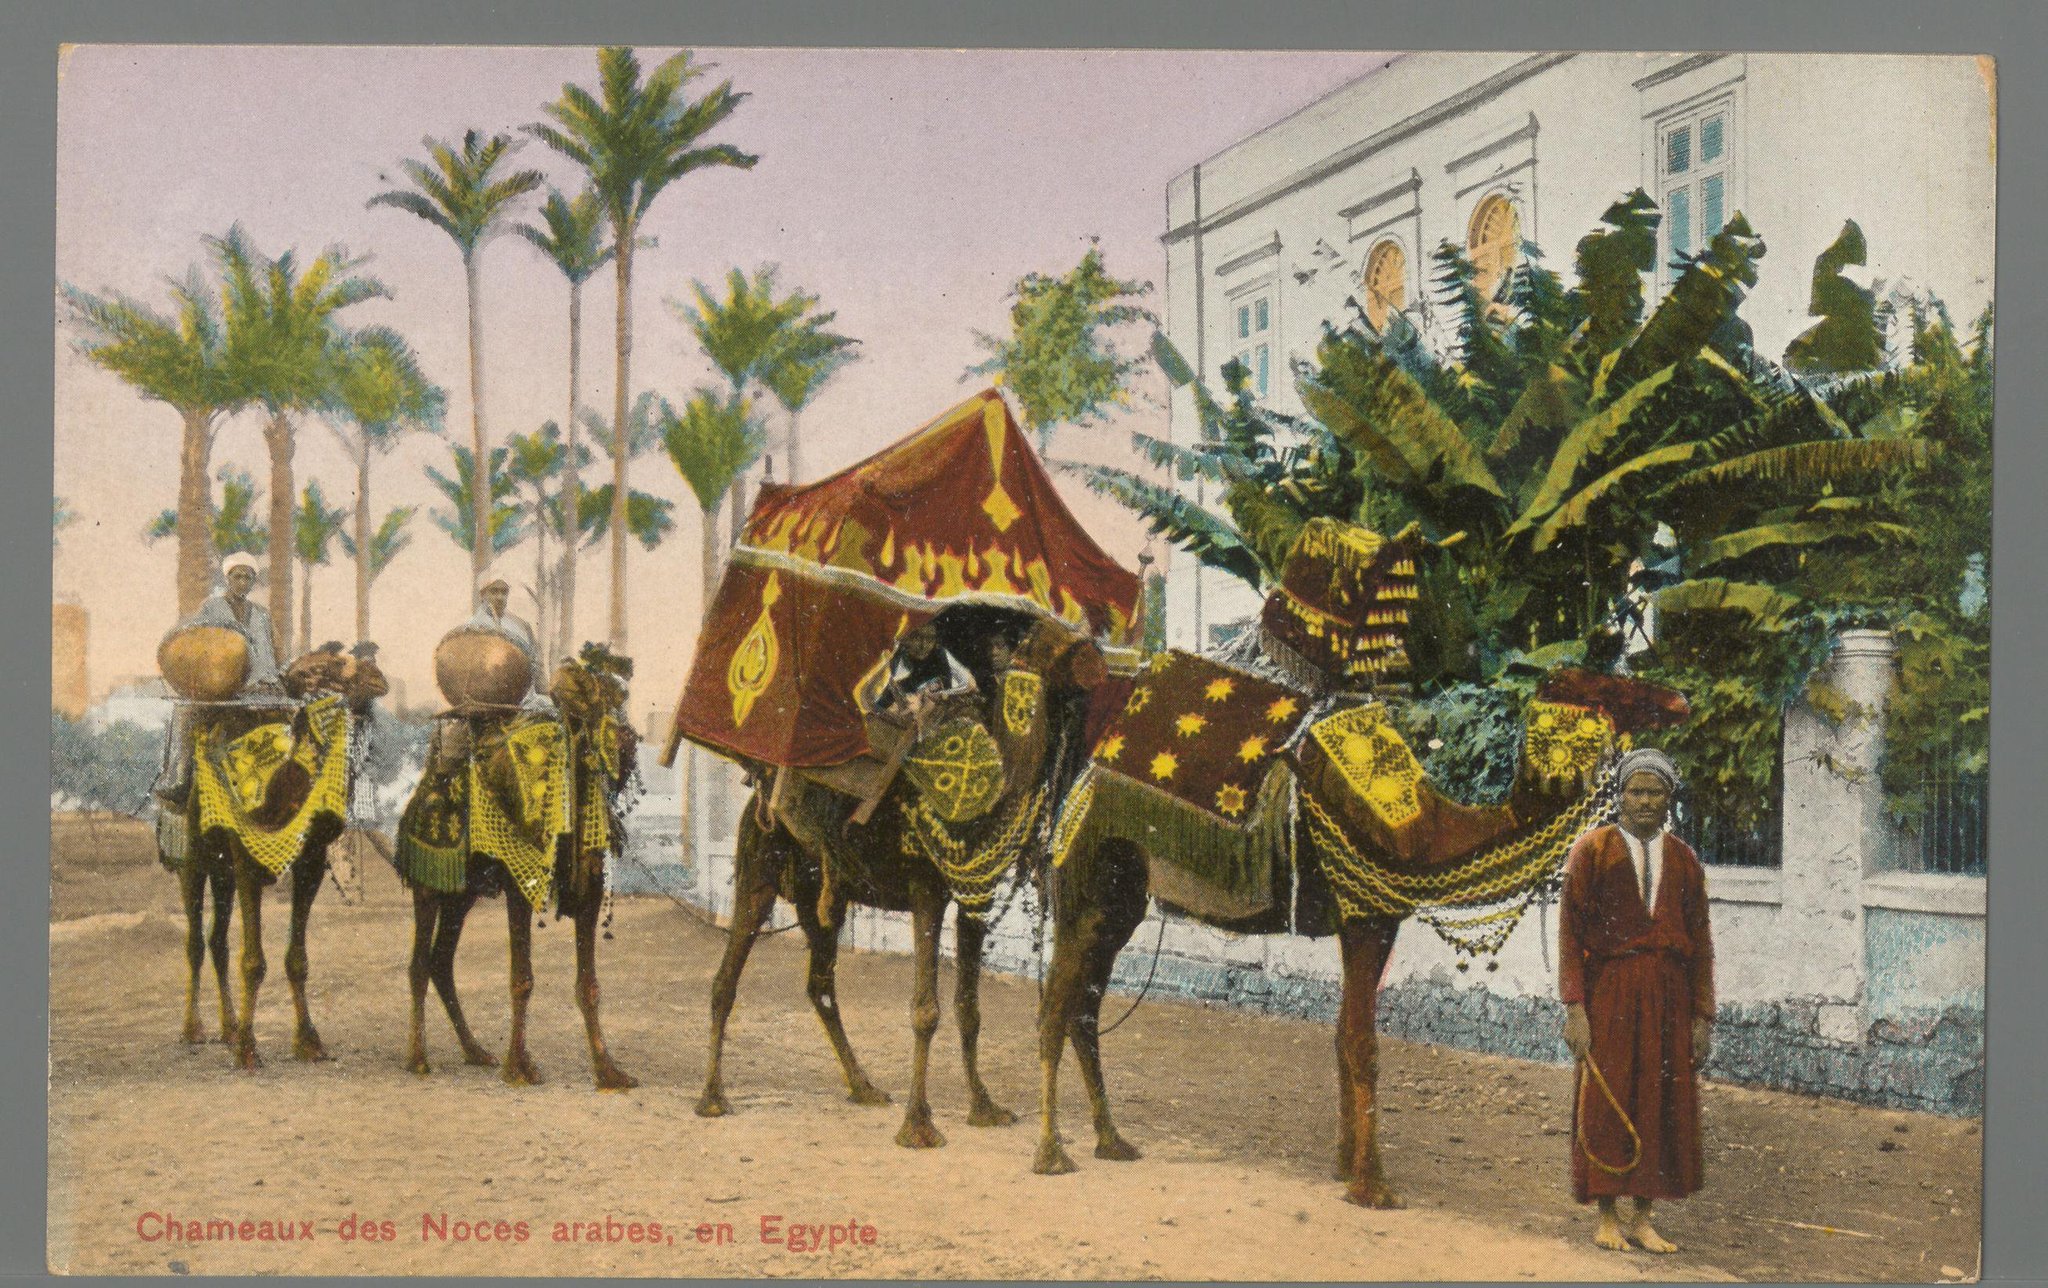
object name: ansichtkaart, prentbriefkaart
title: Chameaux des Noces arabes, en Egypte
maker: Anonymous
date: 1907-1930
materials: cardboard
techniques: lithograph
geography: egypt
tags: wedding-gift